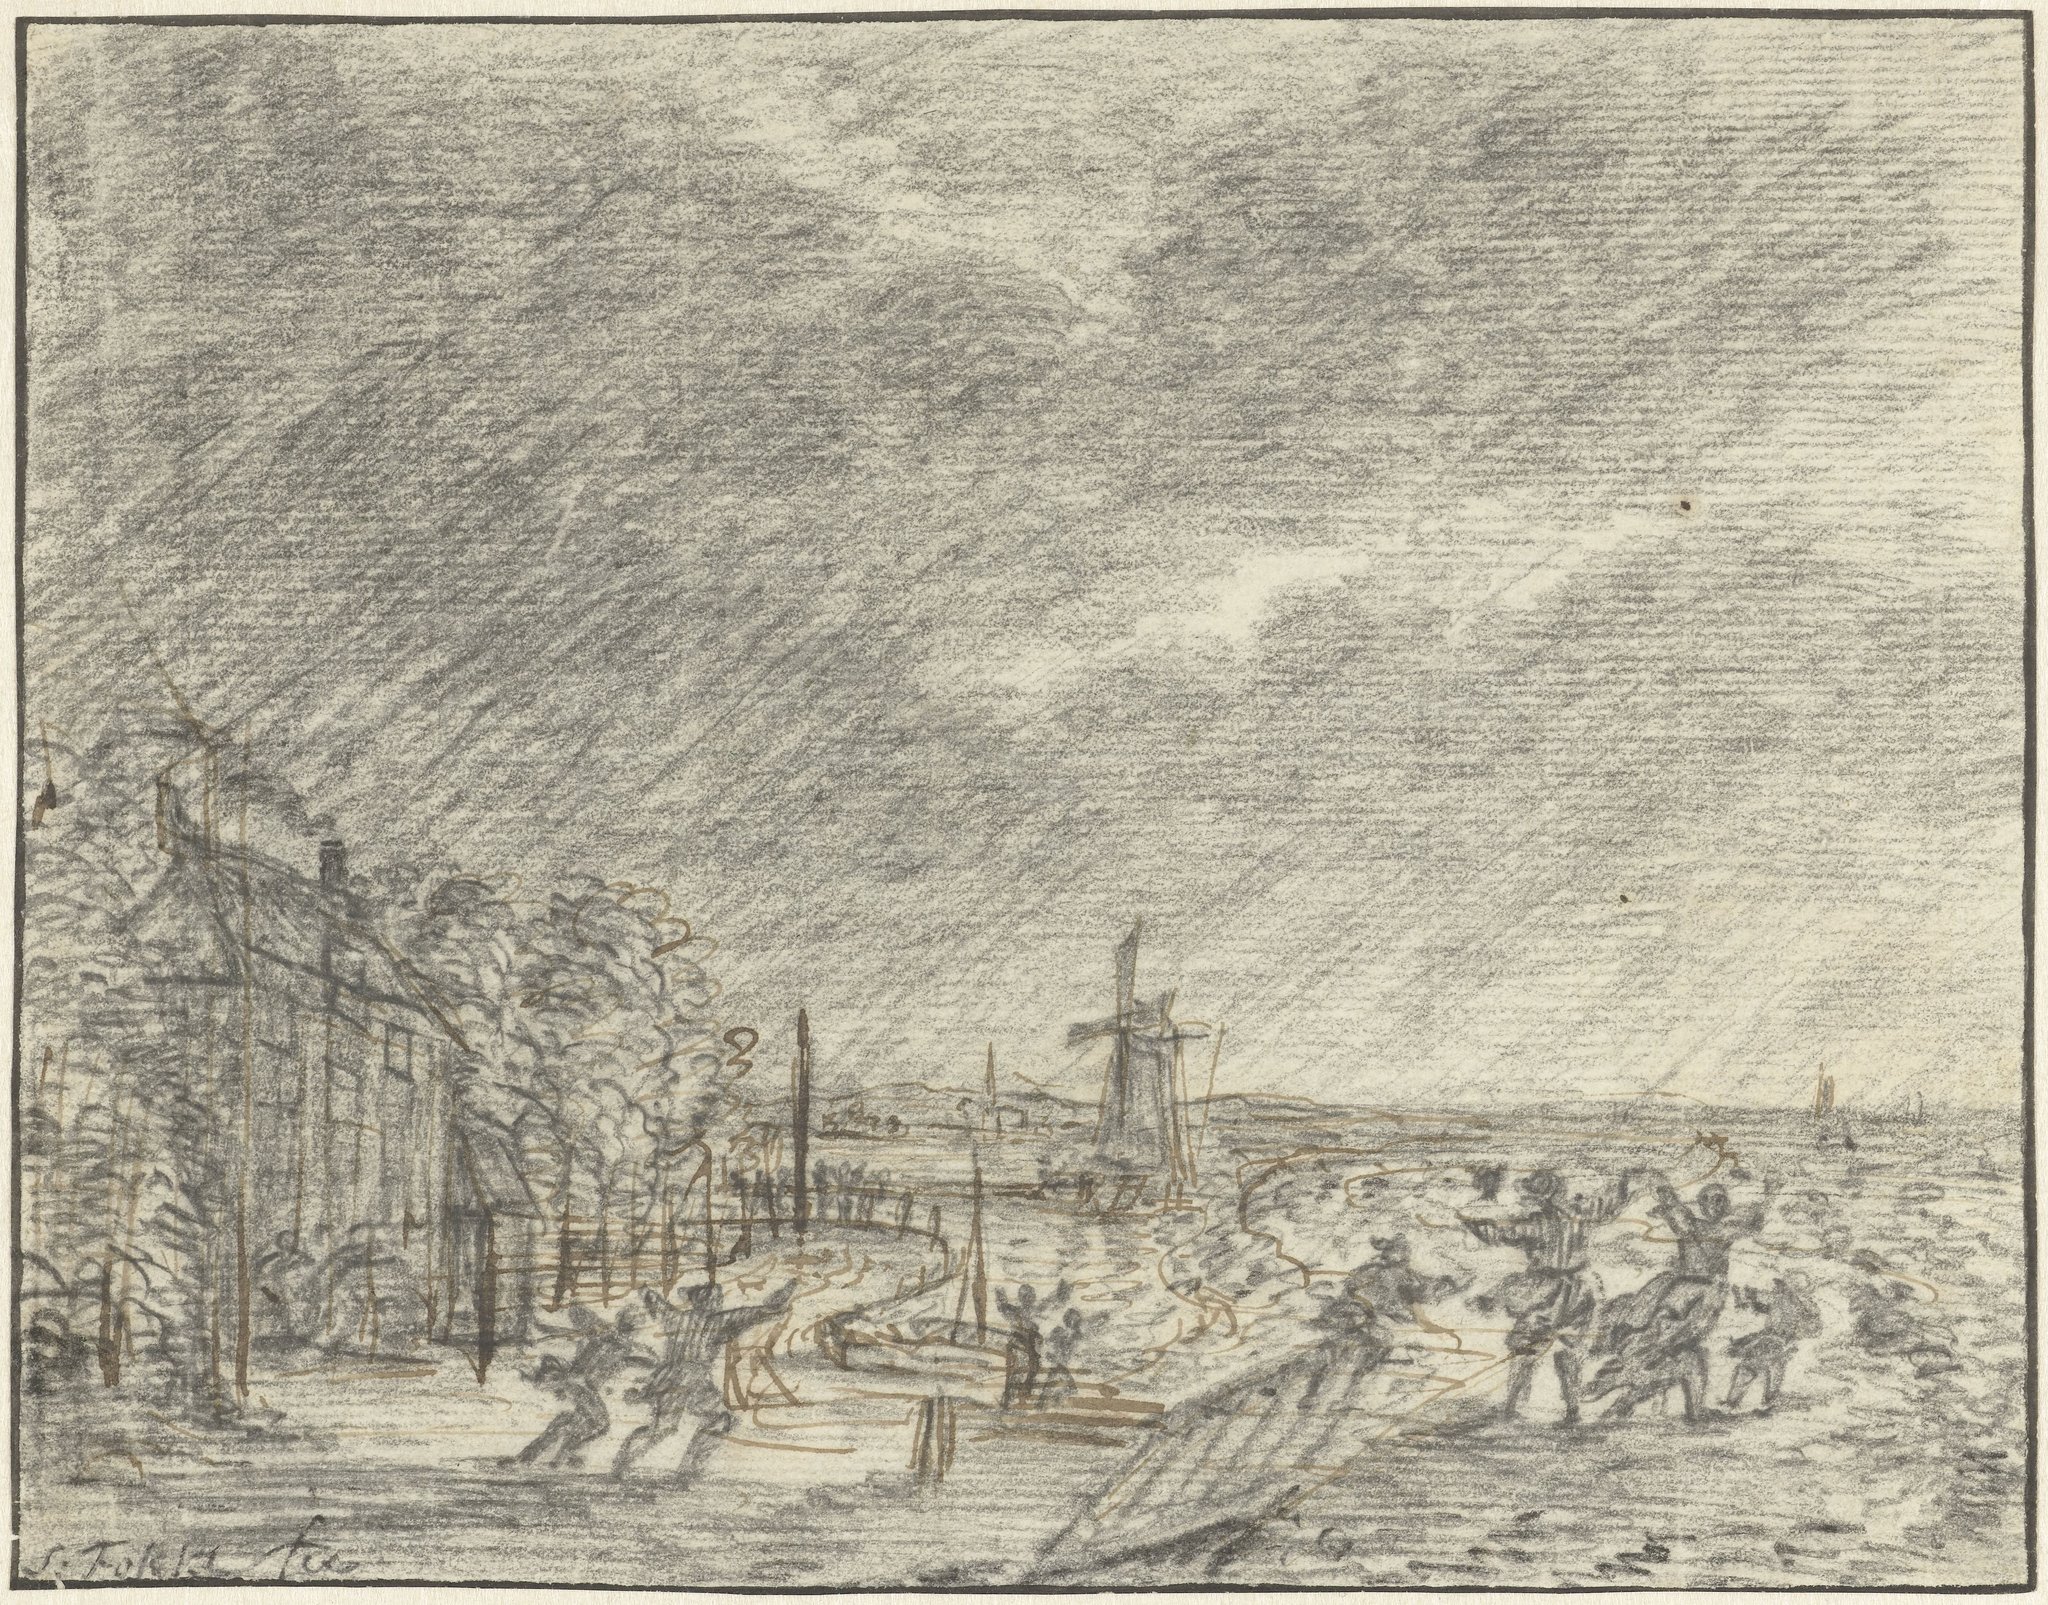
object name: drawing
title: Zware storm en overstroming bij Halfweg, 15 november 1775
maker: simon fokke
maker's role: draughtsman, print maker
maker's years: 1712-1784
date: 1775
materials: chalk, ink, paper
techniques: pen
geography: halfweg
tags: flood, storm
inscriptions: inscription: ‘Gesicht Halfwegen/ Haarlem in den Sware/ Storm S'morgens den 15 Novemb./1775/ na't leven door my geschetst/ S: Fokke fect.’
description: Voorstudie voor ets door S. Fokke (FM4303)